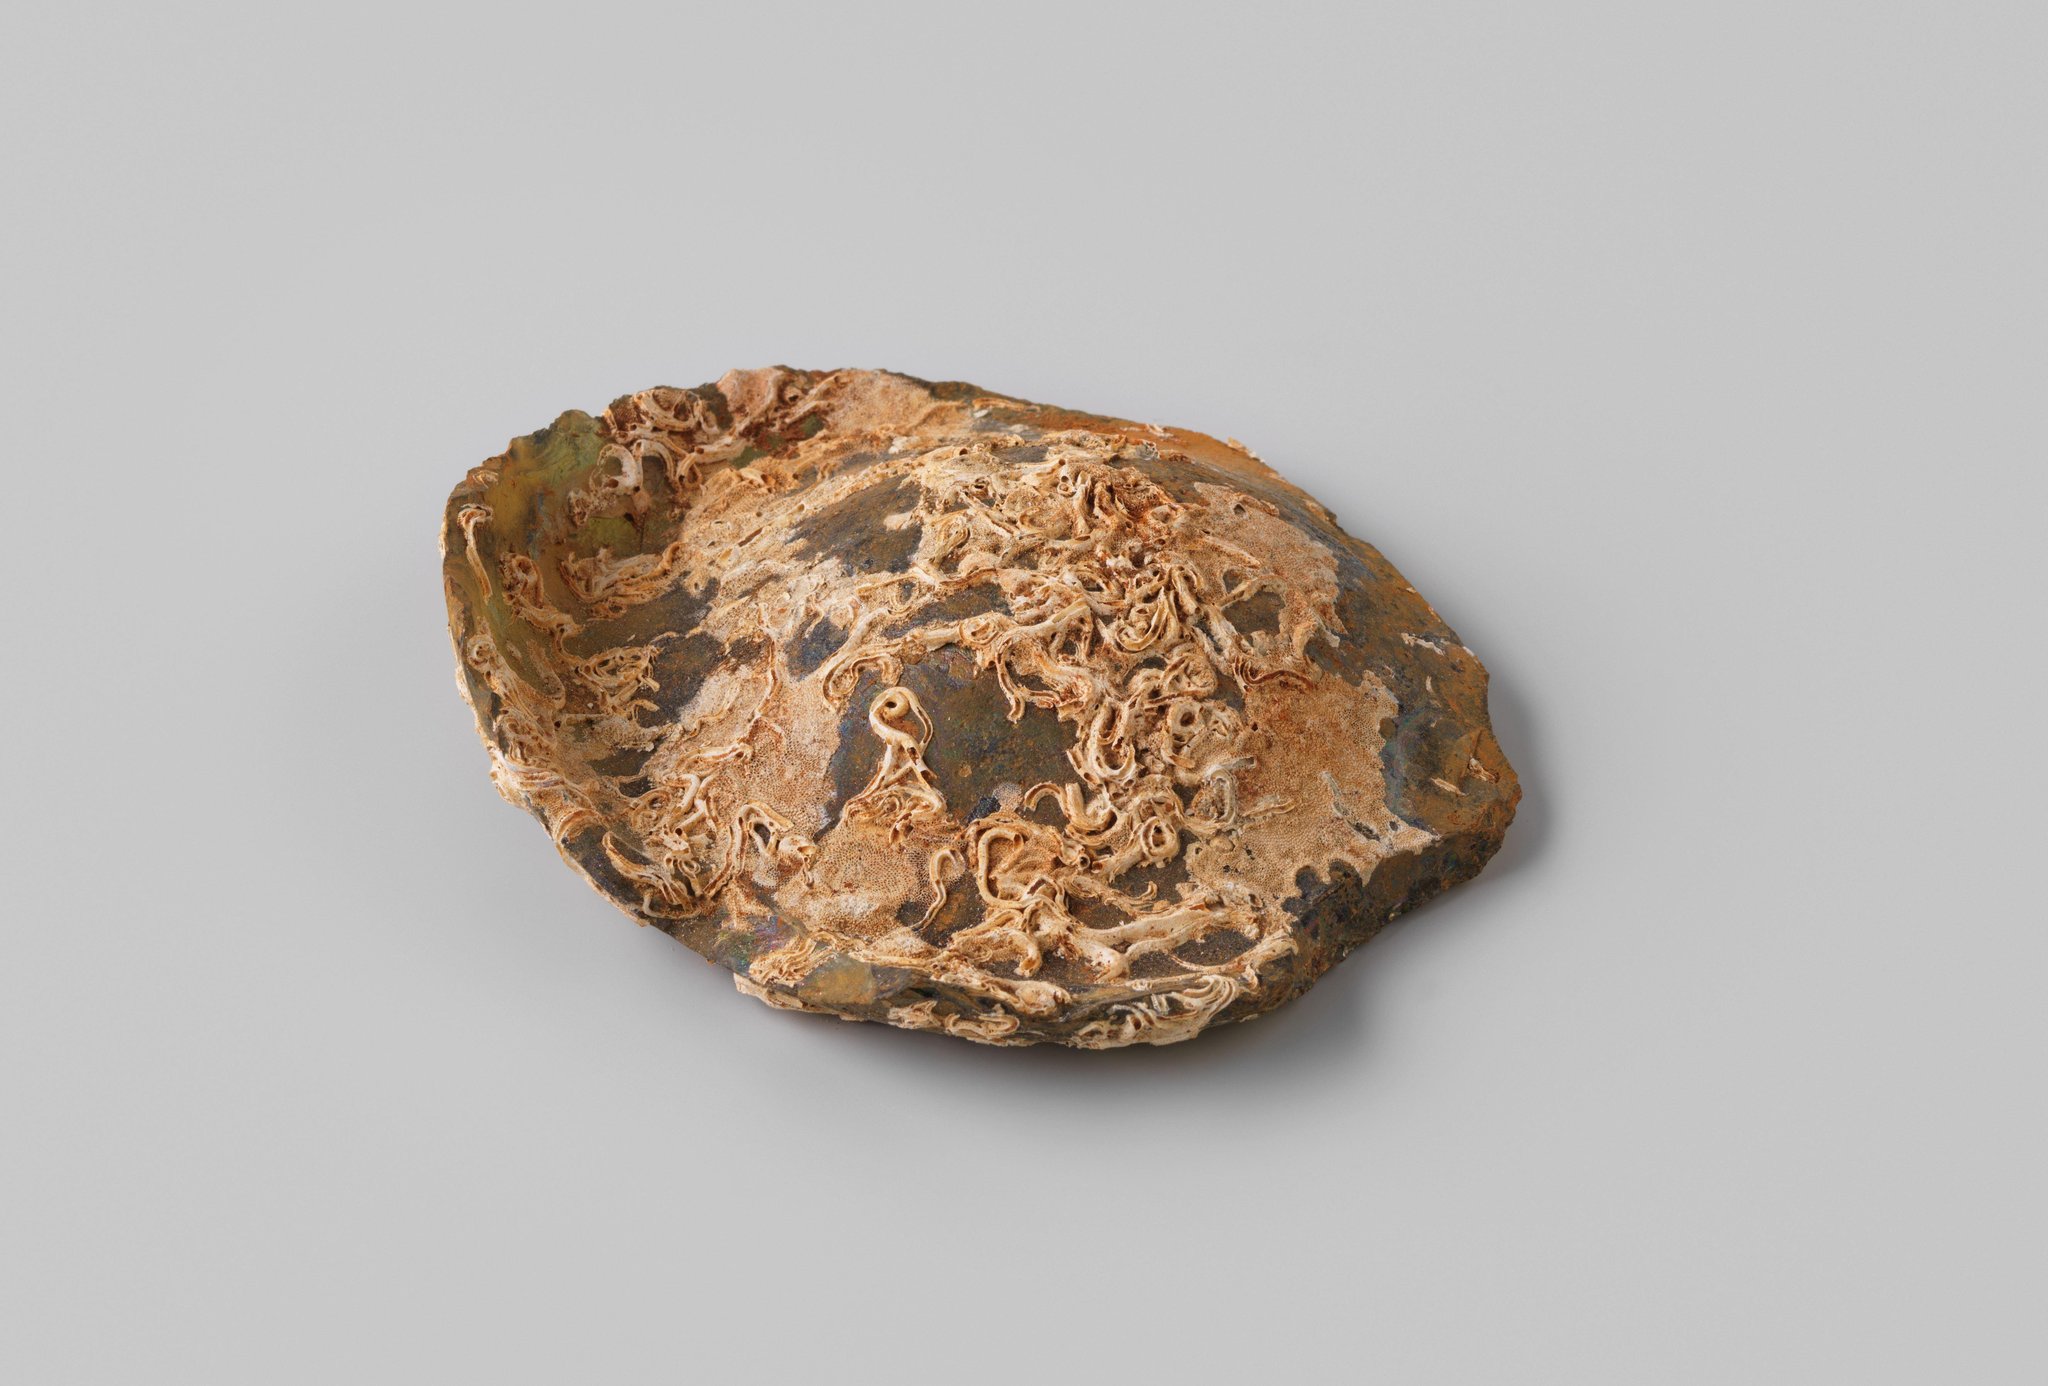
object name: sherd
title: Bodemfragment wijnfles uit het wrak van de Oost-Indiëvaarder Hollandia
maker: Anonymous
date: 1700-1743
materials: glass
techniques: green glass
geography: netherlands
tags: verenigde oostindische compagnie, hollandia (schip), annet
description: Onion-shaped bottle or bottle with vertical side, base, tcs-kick-up. Continental production.